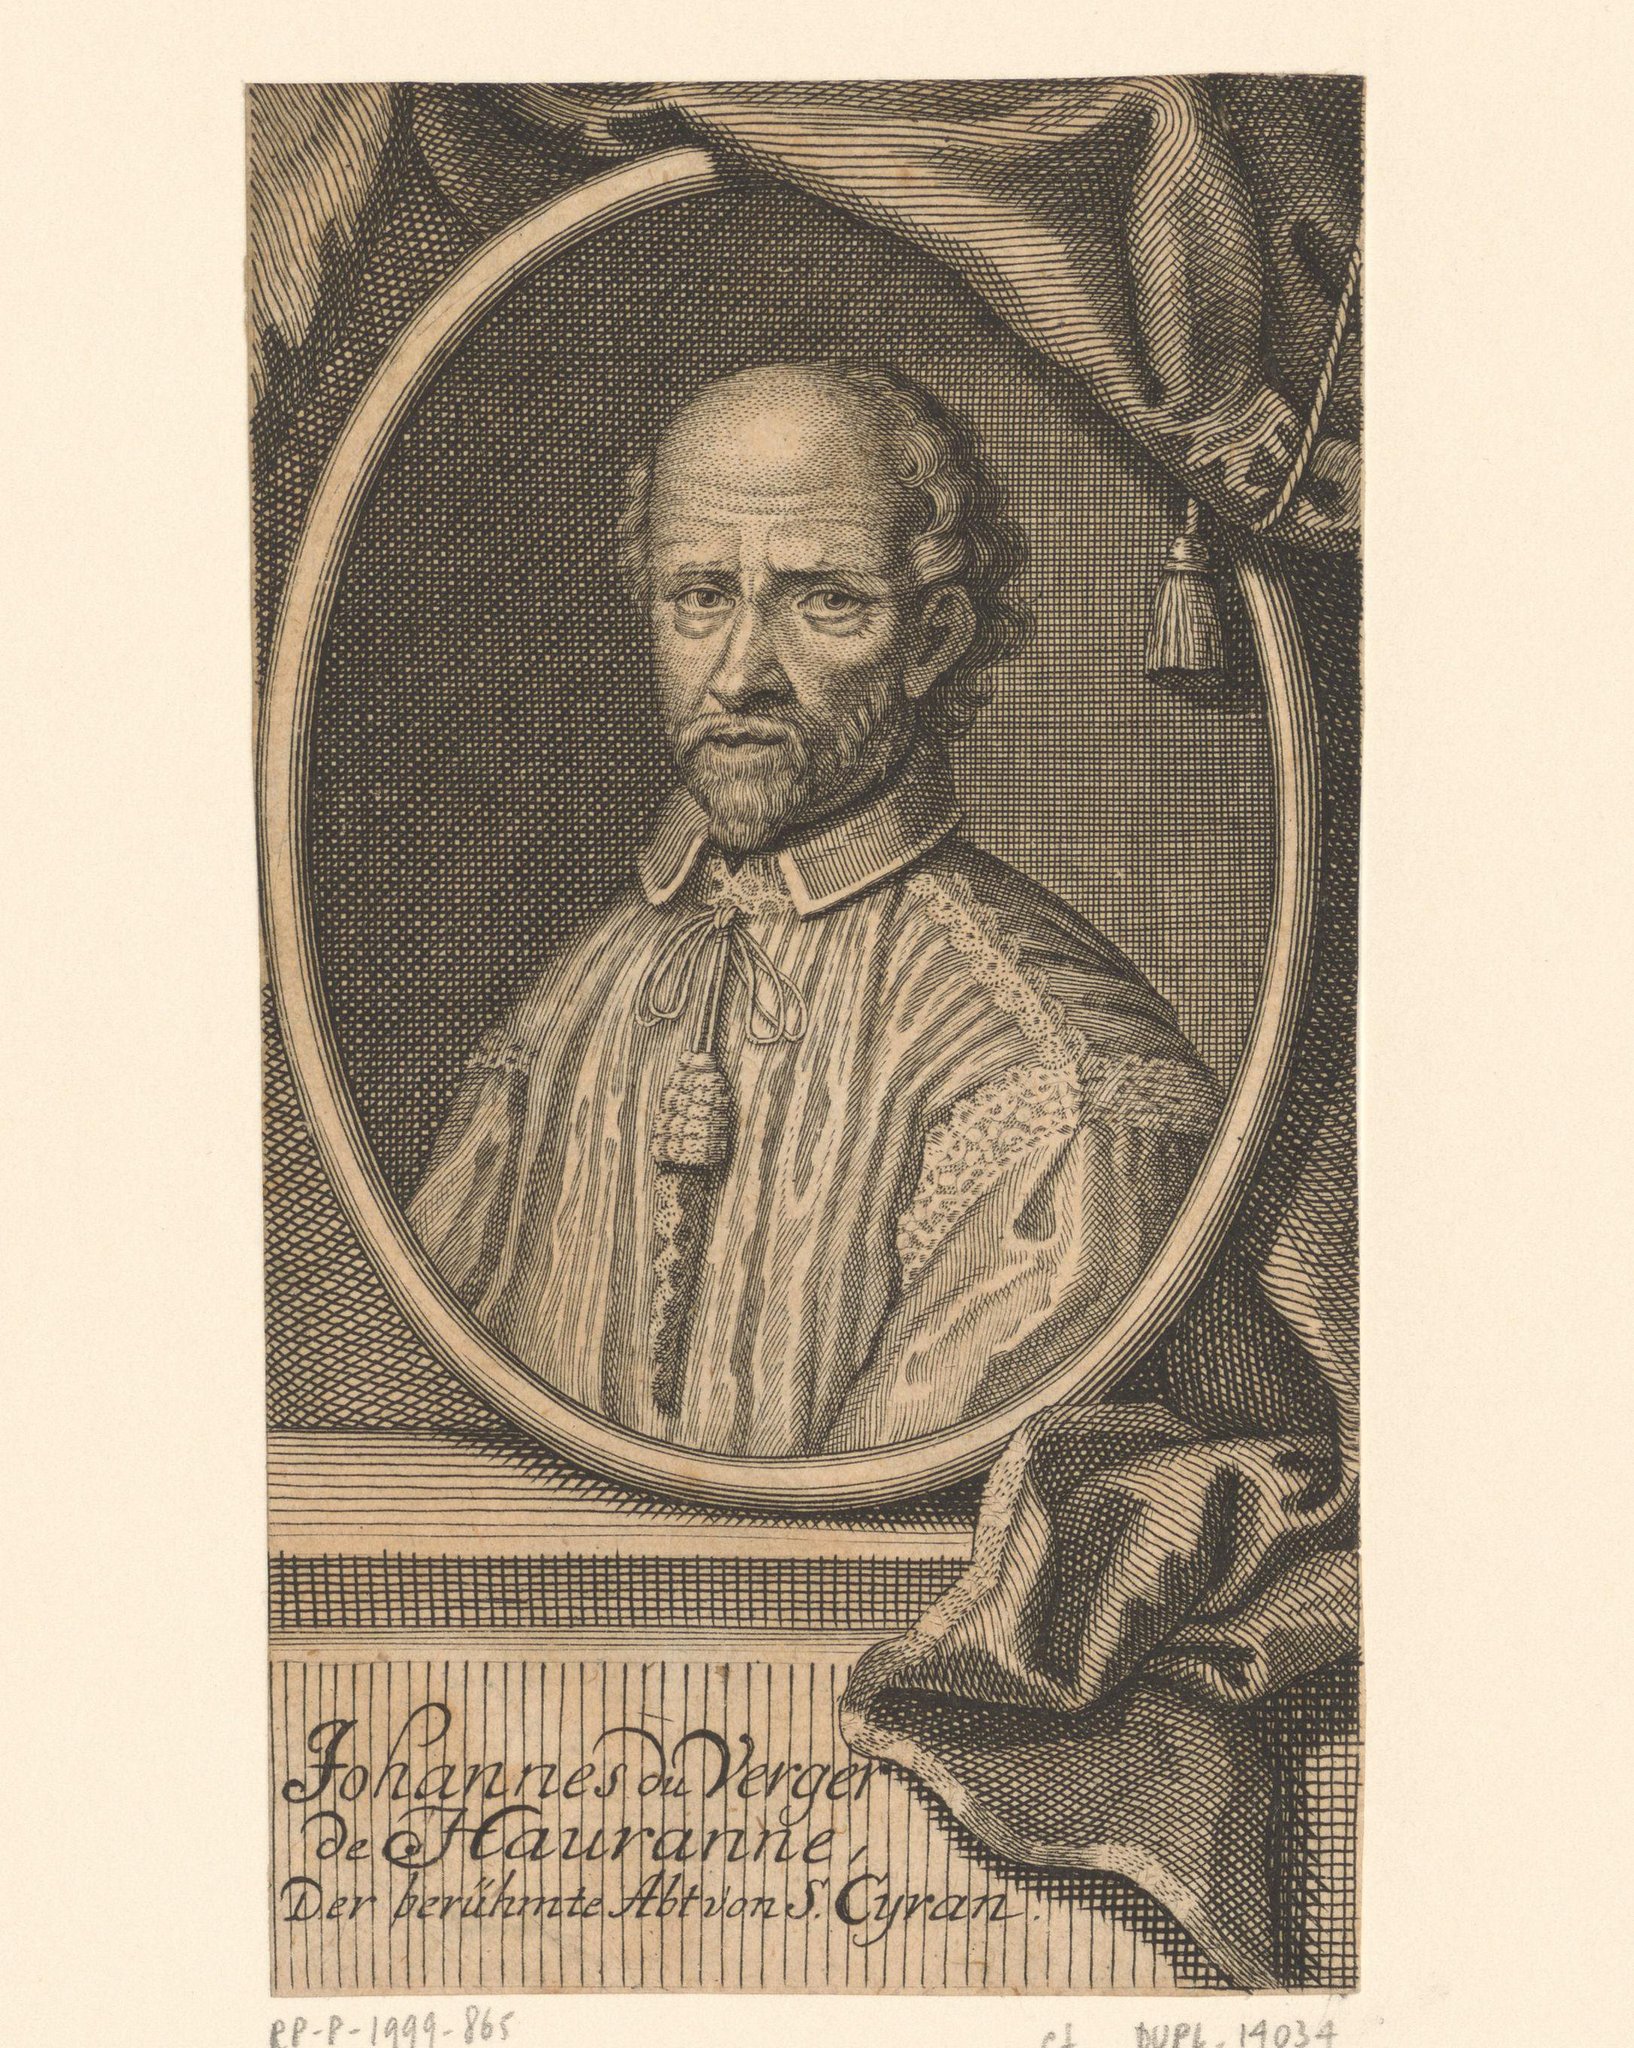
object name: print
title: Portret van Johannes Duvergier de Hauranne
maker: Anonymous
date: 1712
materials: paper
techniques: engraving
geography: france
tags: paris, priest, theologian, abbot, historical persons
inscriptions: collector's mark: Lugt 2228, collector's mark: Lugt 2760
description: Johannes Duverger de Hauranne (1581-1643) was een van de oprichters van het Jansenisme en abt van Saint-Cyran. Buste naar links, in ovale lijst met draperie, op een stenen sokkel. Op de sokkel staat zijn naam en zijn functie van abt van S. Cyran.